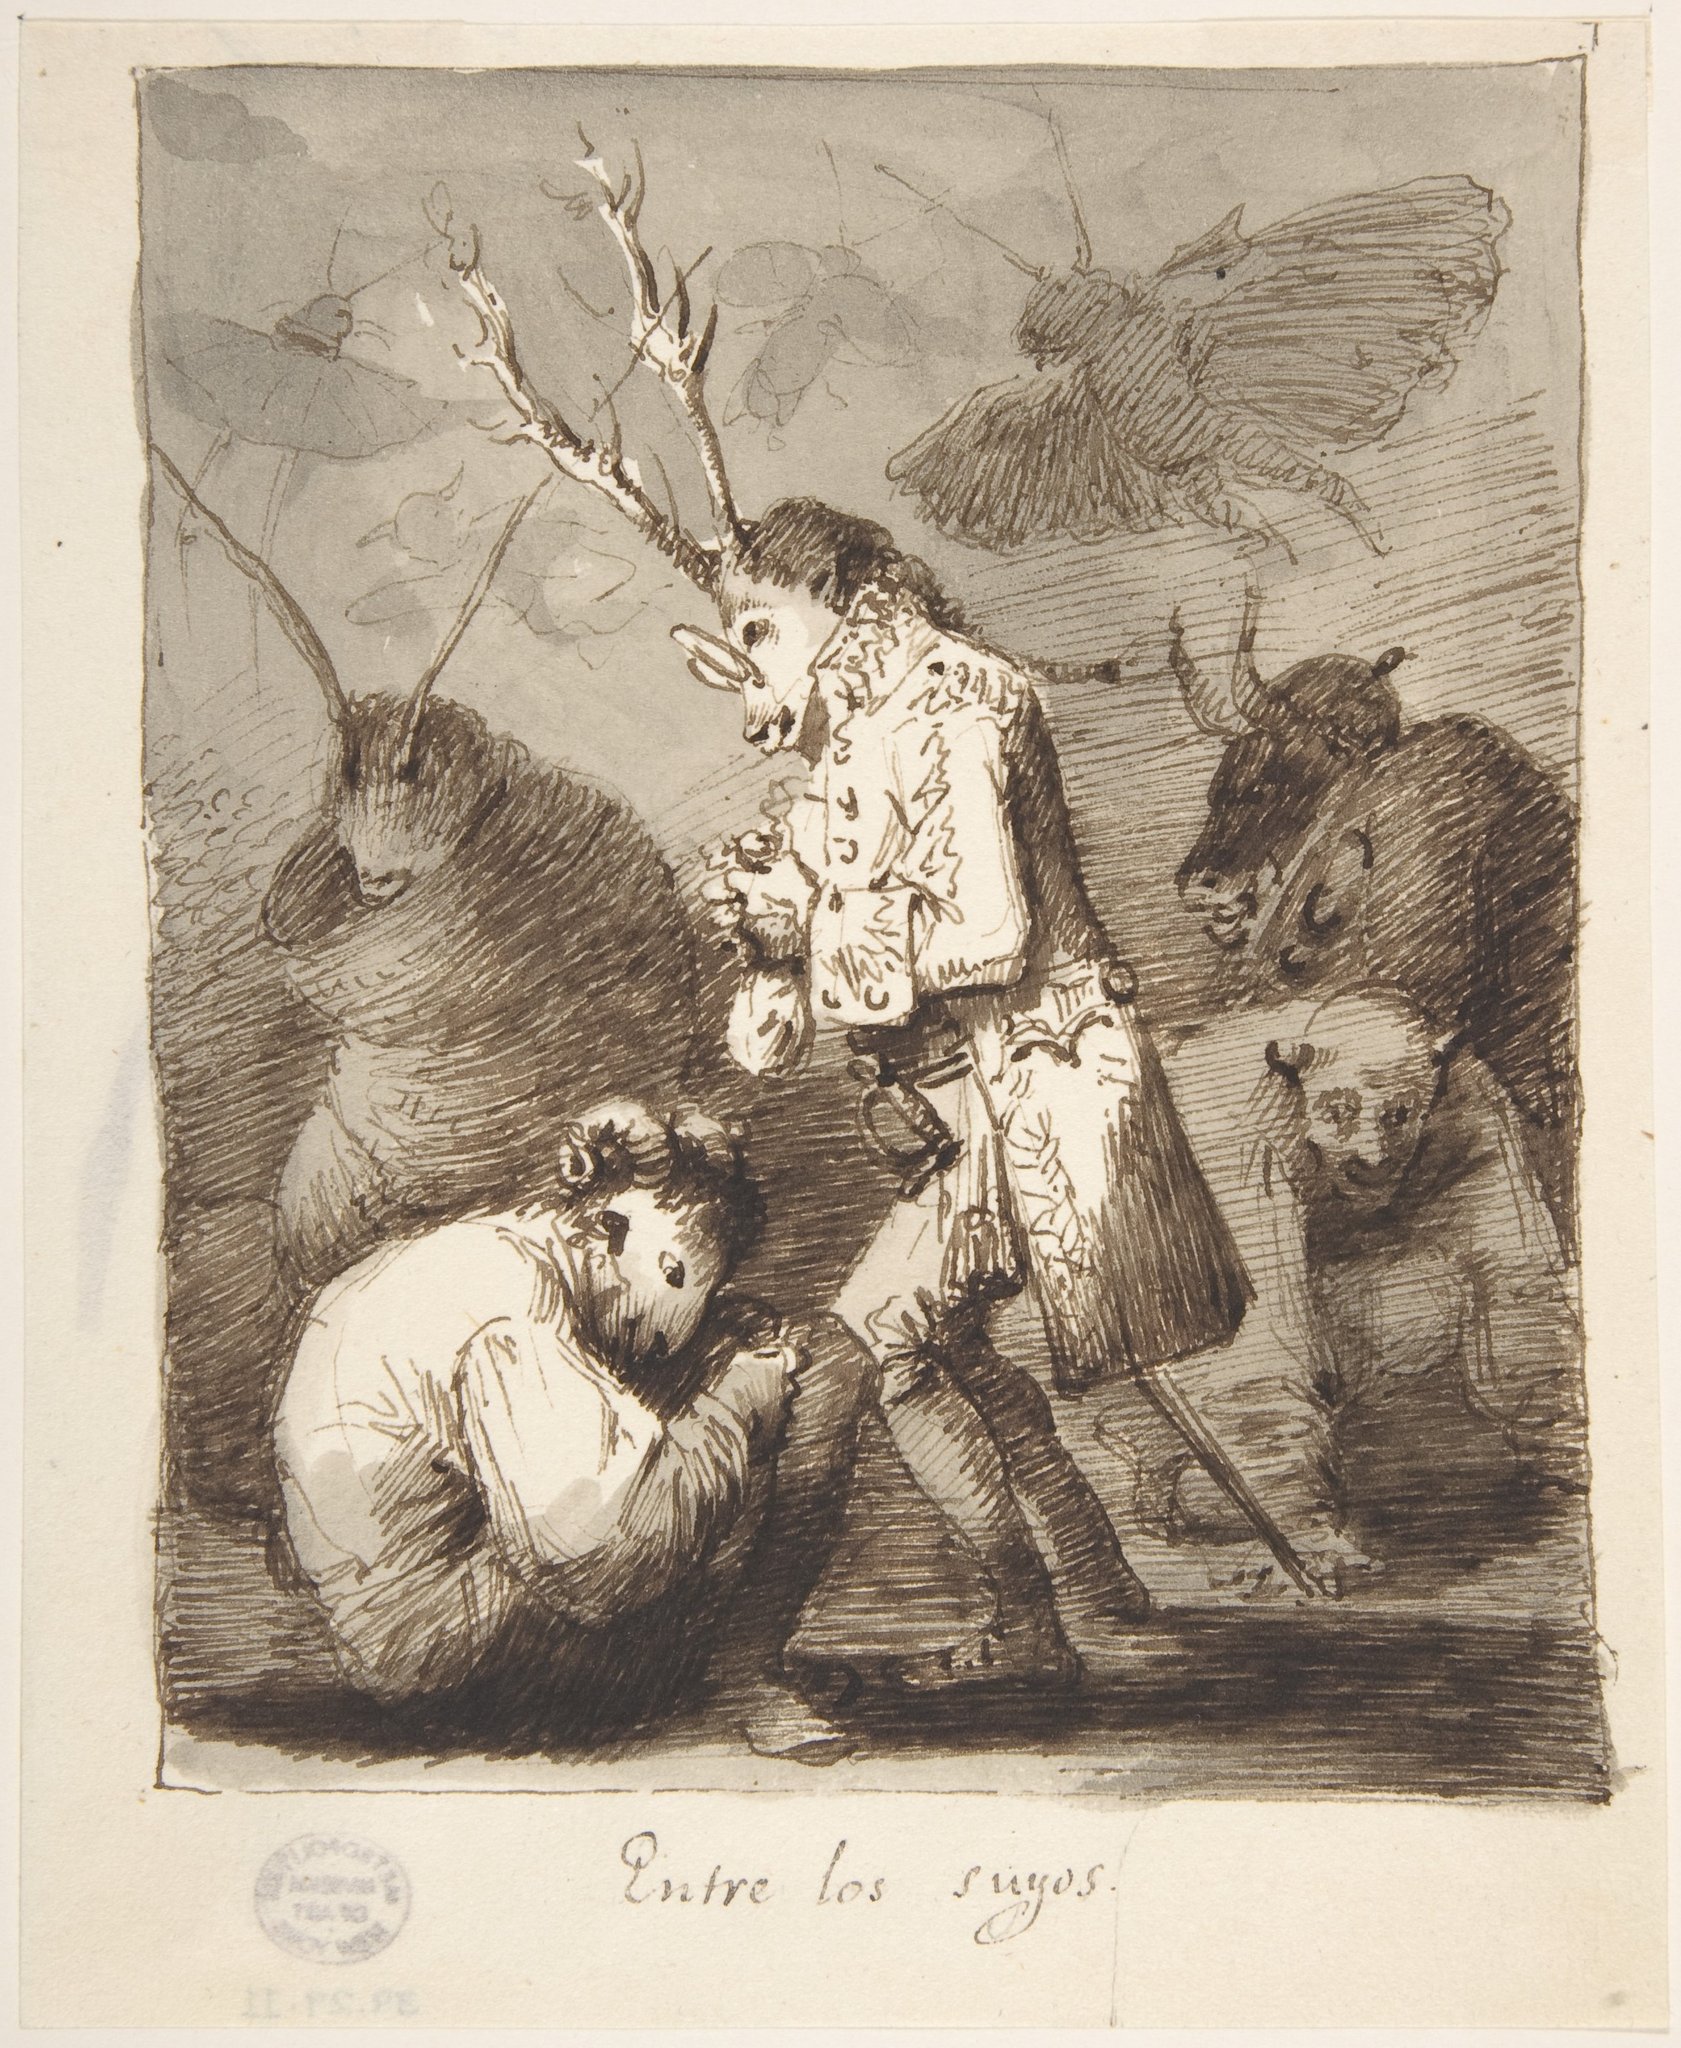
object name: drawing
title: Birds of a Feather (Entre los suyos)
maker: leonardo alenza y nieto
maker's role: artist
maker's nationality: spanish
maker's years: 1807-1845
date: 1807-1845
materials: chalk, ink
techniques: pen